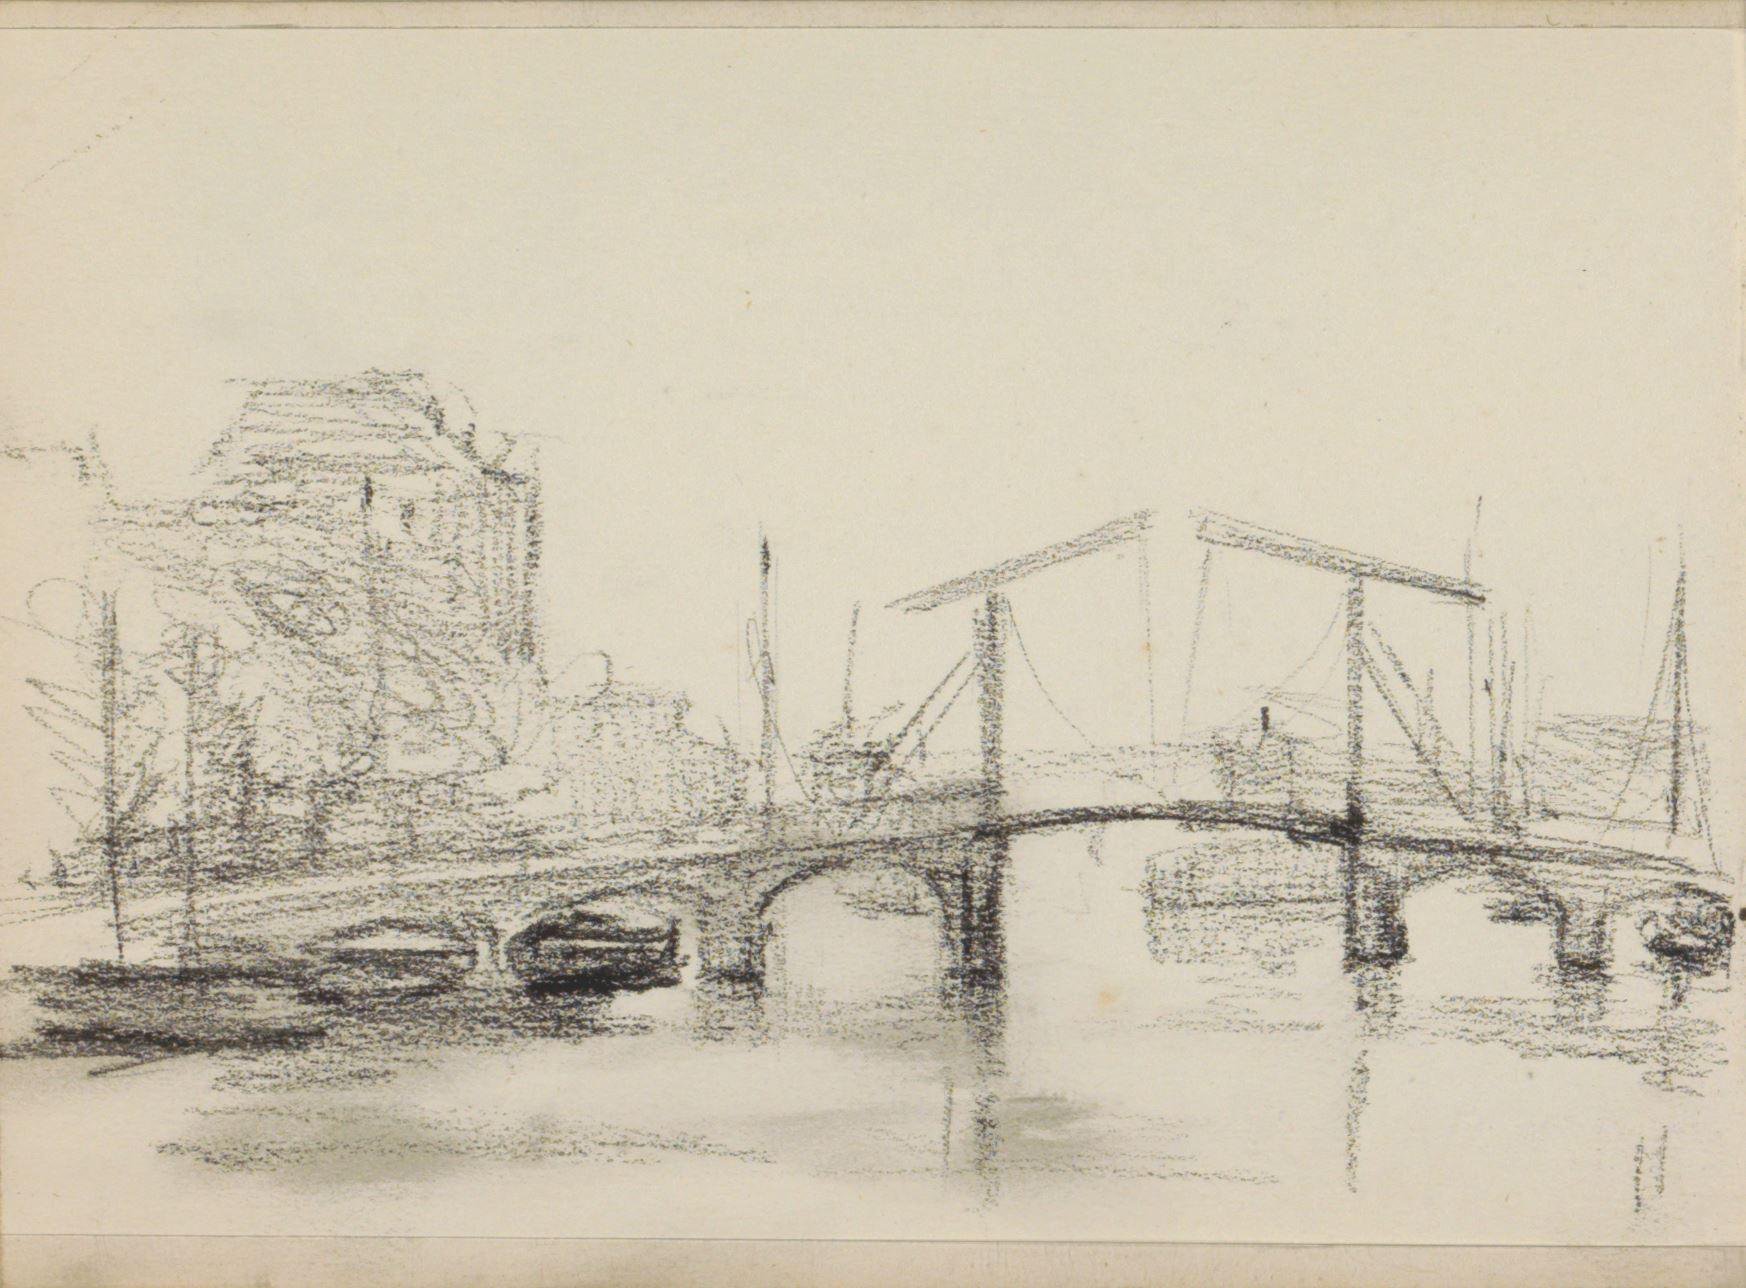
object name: sketchbook leaf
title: De Magere Brug in Amsterdam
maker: a.a.l. de grammont-hubrecht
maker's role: draughtsman, painter, print maker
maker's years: 1855-1913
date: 1865-1913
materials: chalk, paper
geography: amsterdam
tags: bridge in city across river, canal, etc.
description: Blad 33 verso uit een schetsboek met 38 bladen.